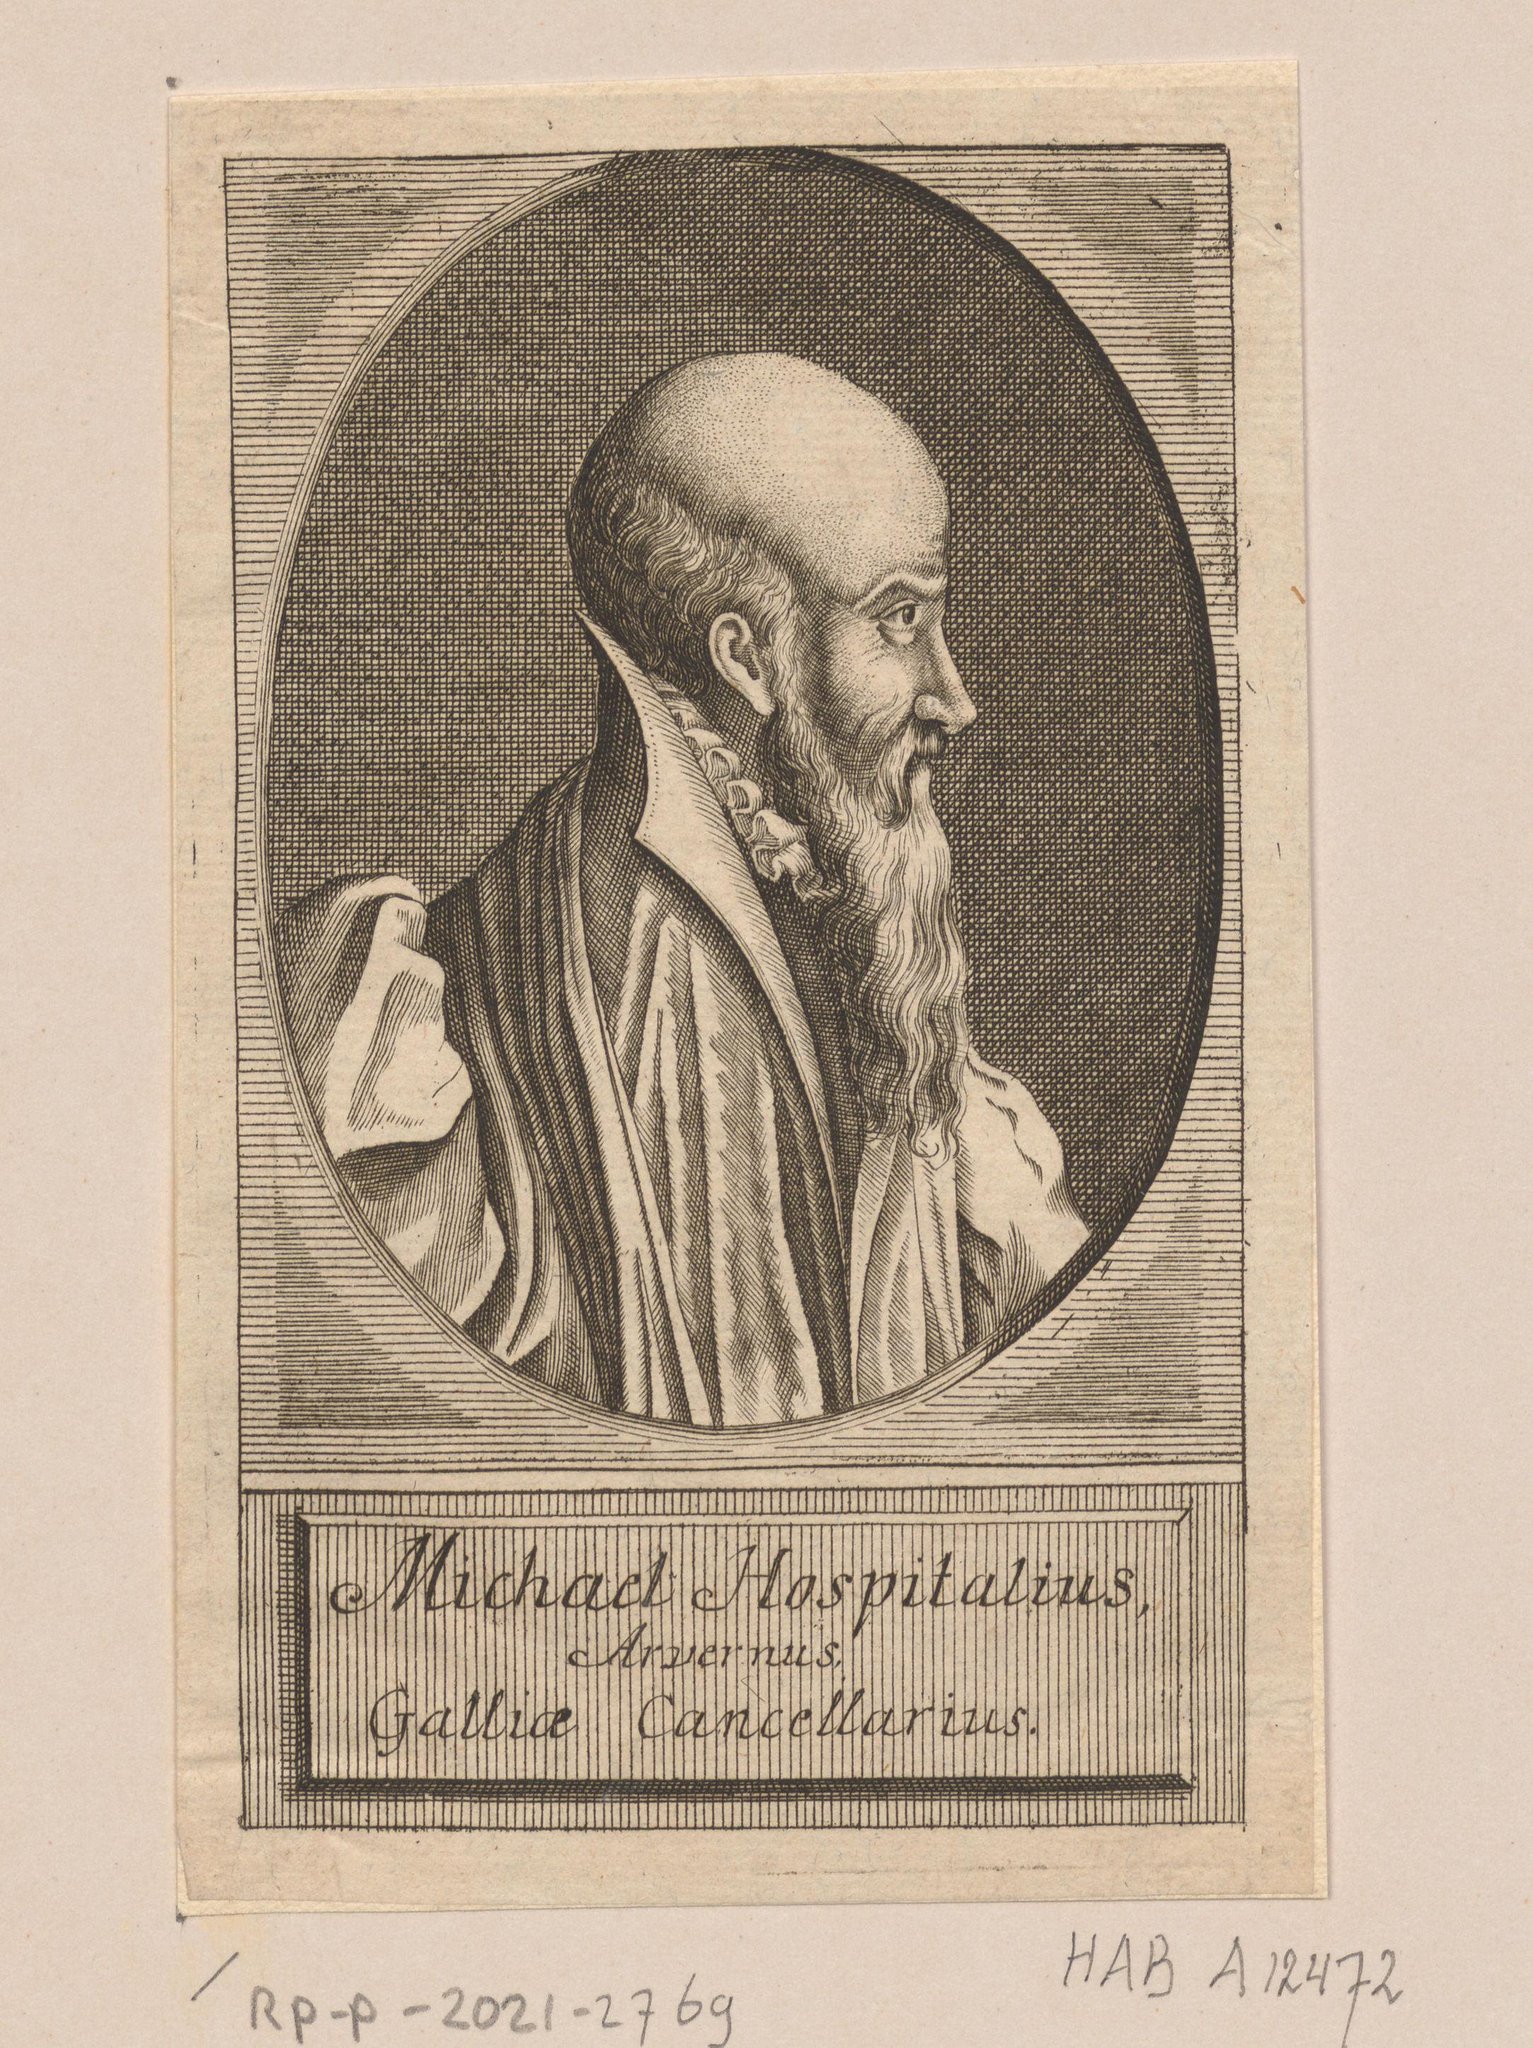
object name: book illustration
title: Portret van Michel de L'Hospital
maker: Anonymous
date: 1714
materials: paper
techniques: engraving, etching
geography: germany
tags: ornament ~ medallion, historical persons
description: Prent waarschijnlijk uit: Neue Bibliothec Oder Nachricht und Urtheile von neuen Büchern Und allerhand zur Gelehrsamkeit dienenden Sachen (1714), nr. 35.